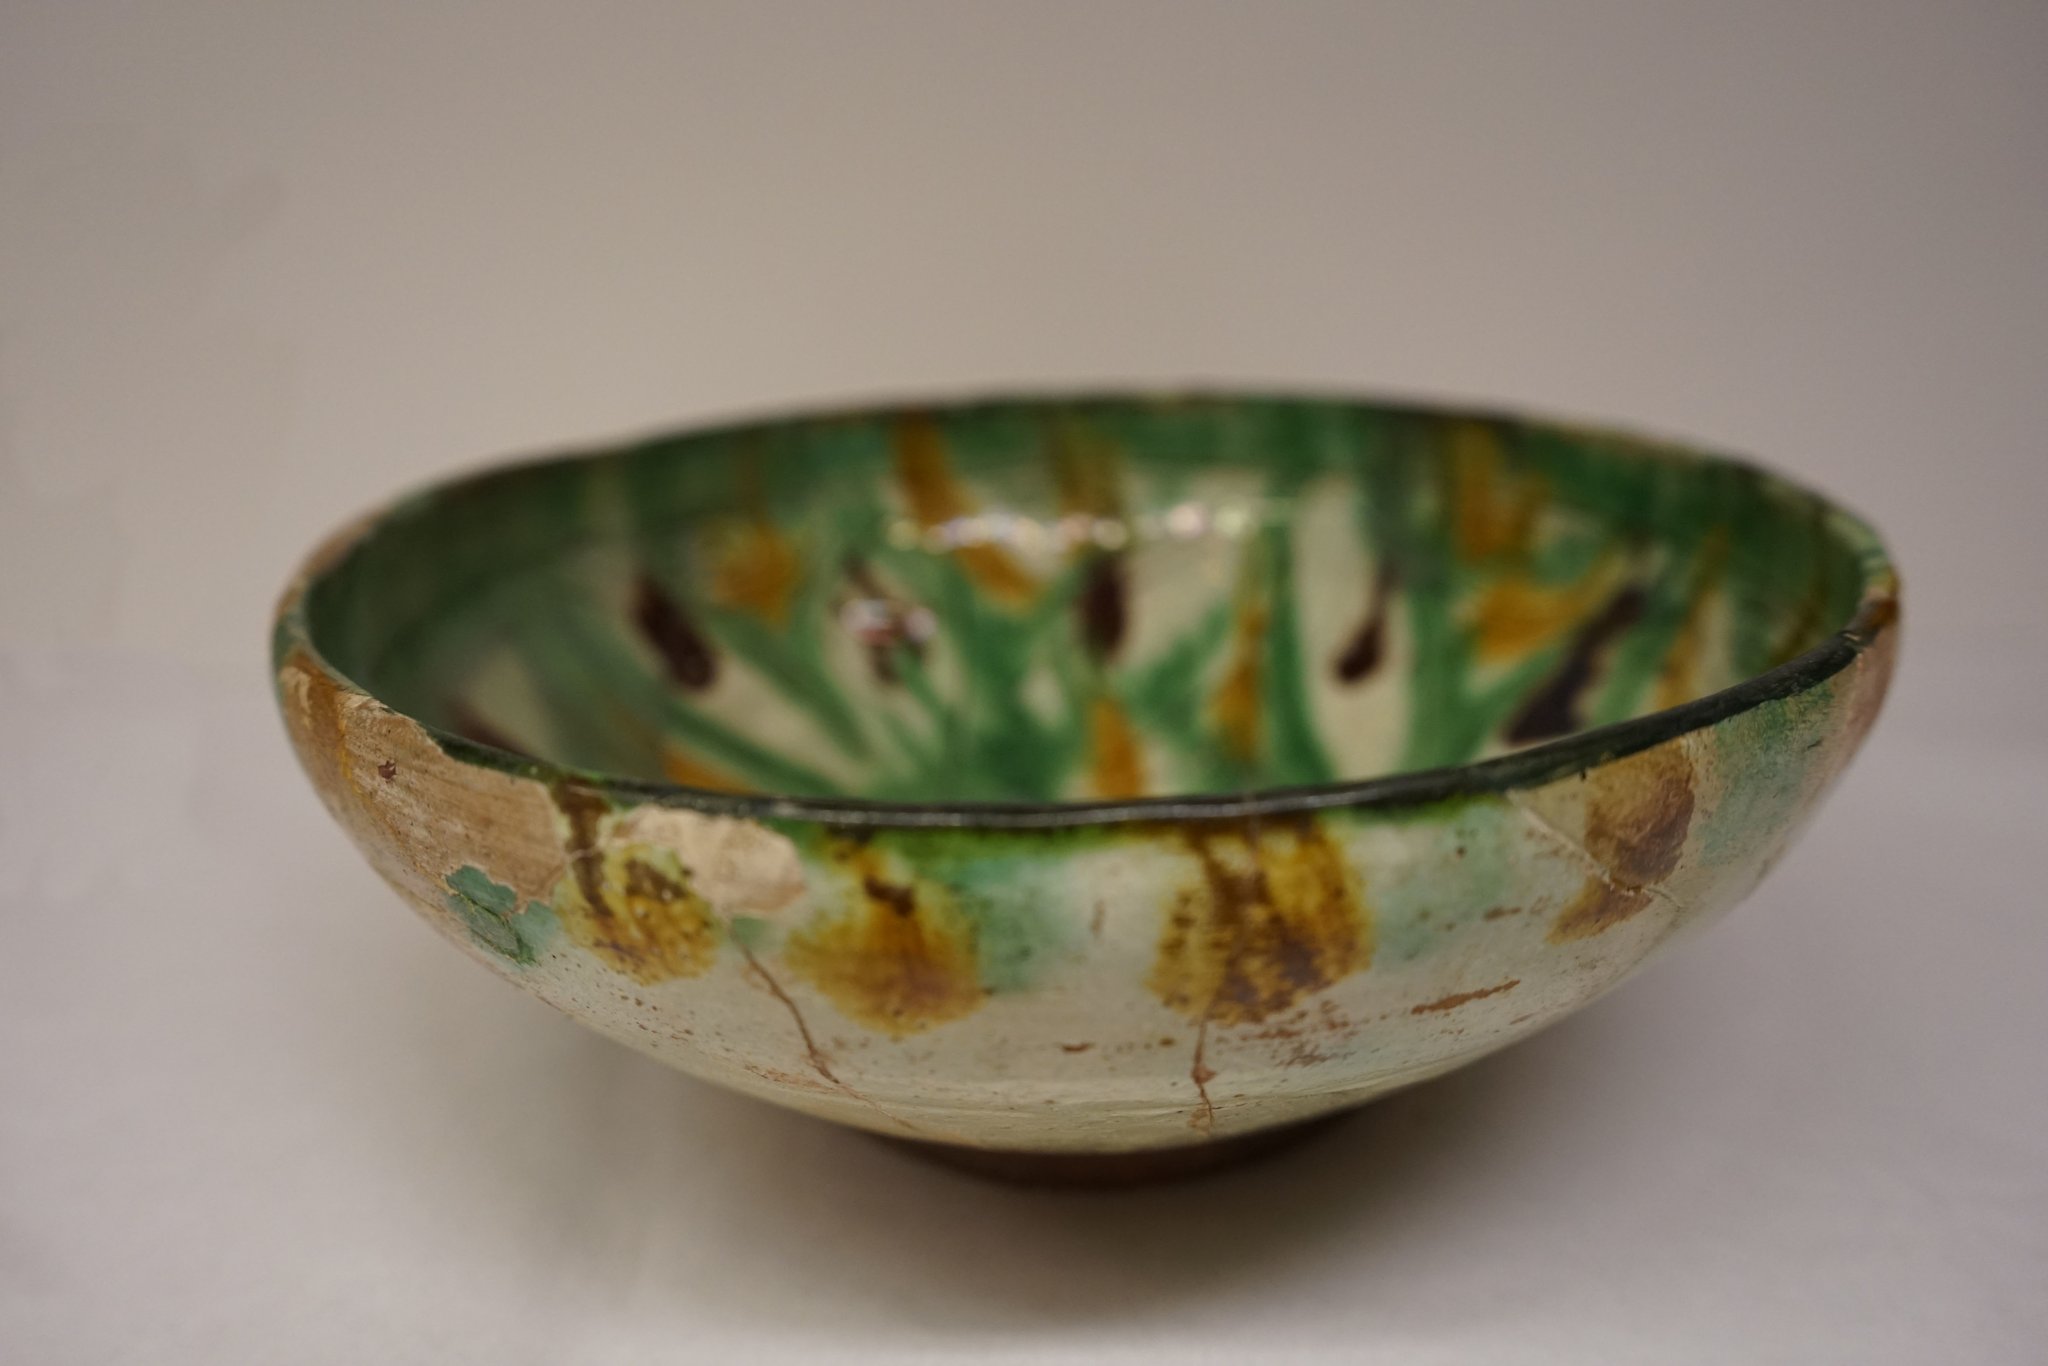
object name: bowl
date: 801-1000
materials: earthenware, glaze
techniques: incising, polychrome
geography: iran